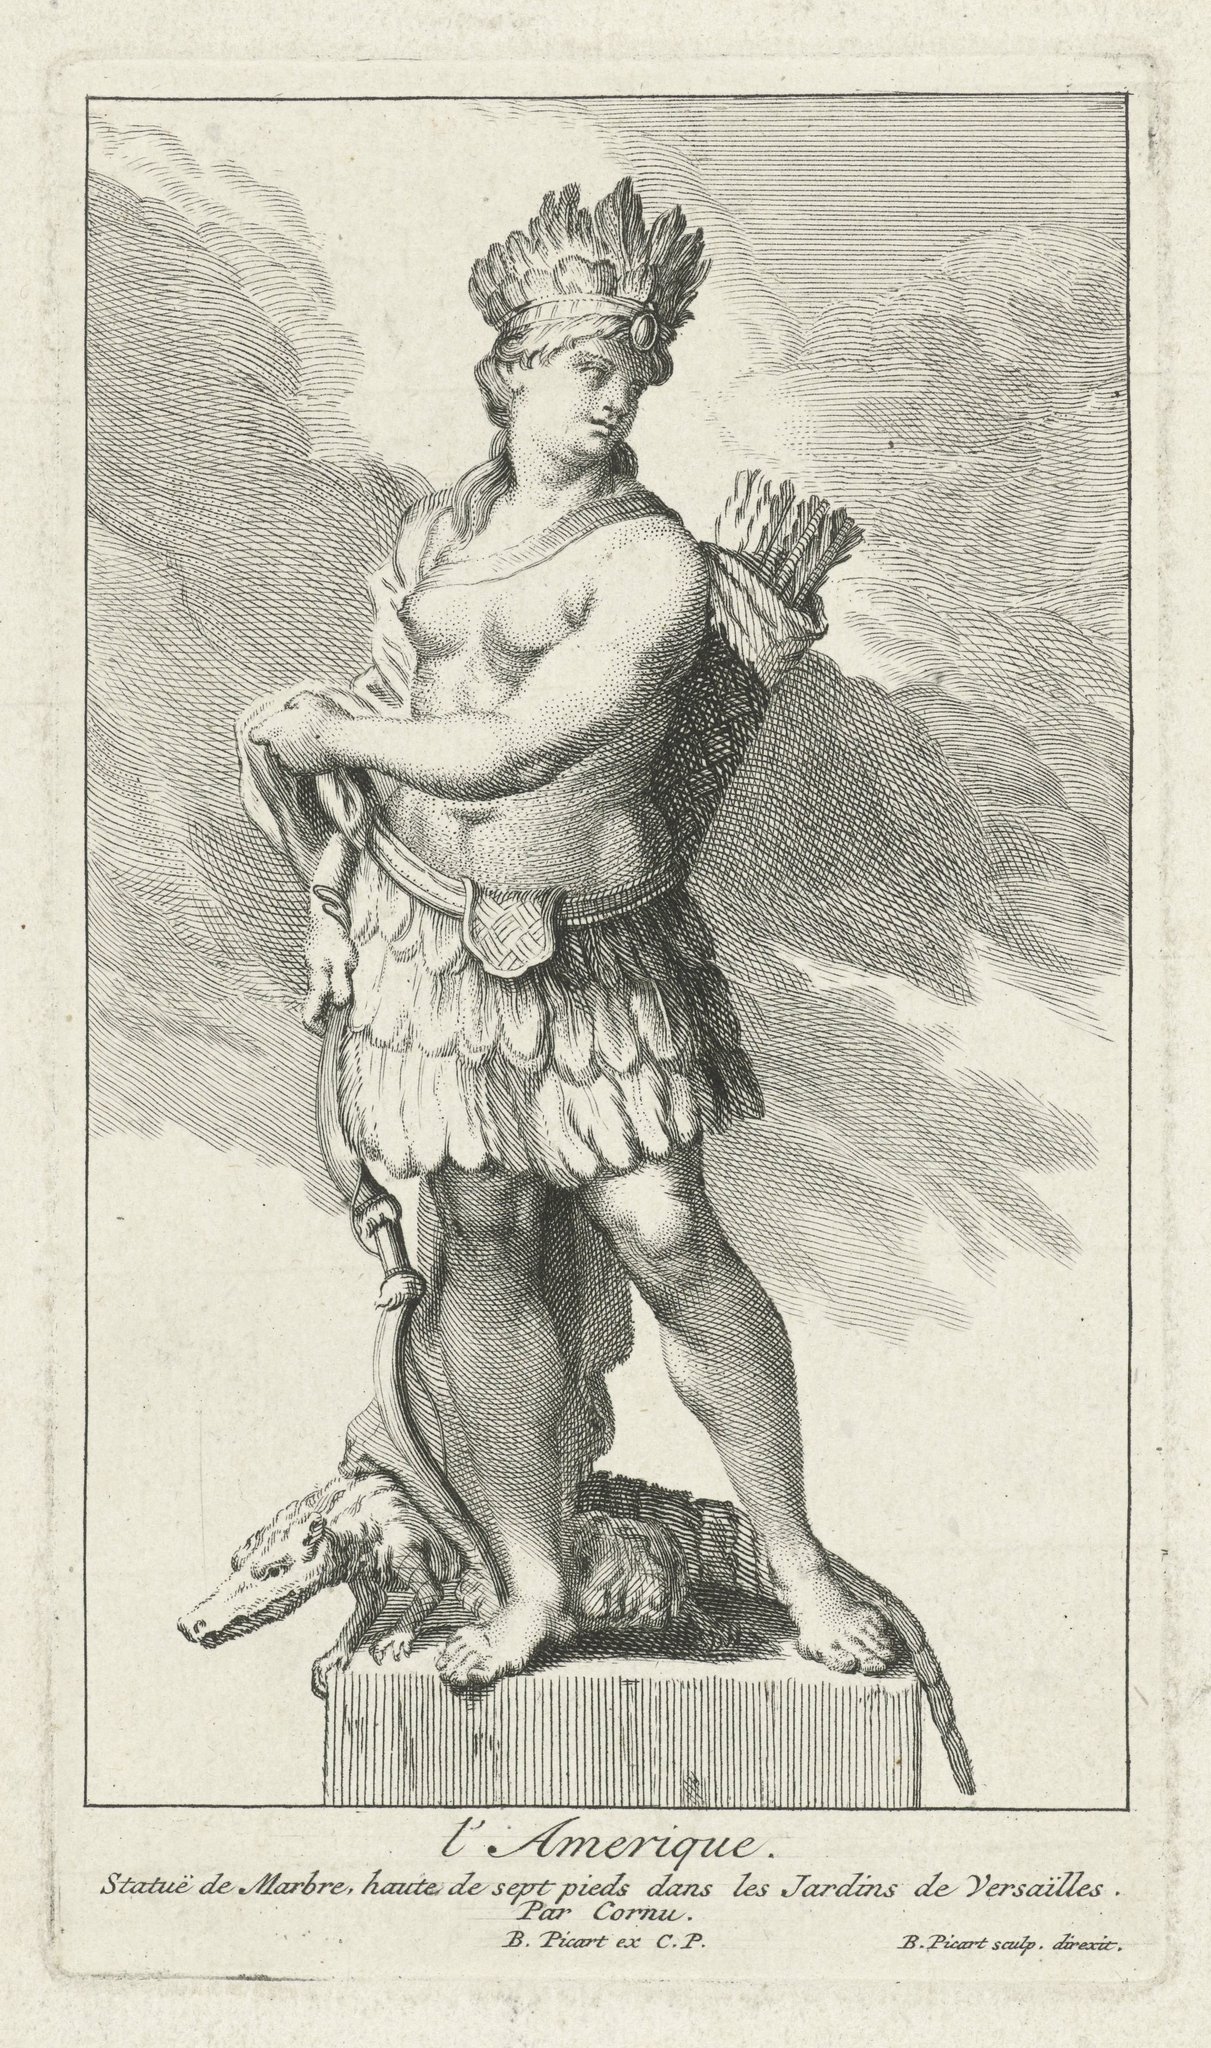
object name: print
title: Amerika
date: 1709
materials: paper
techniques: engraving, etching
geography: paris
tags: america represented allegorically; 'america' (ripa), piece of sculpture, reproduction of a piece of sculpture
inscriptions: collector's mark: Lugt 240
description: Standbeeld in de tuinen van Versailles. De vrouwelijke personificatie van Amerika, met een hoofdtooi, een pijlenkoker op de rug en een boog in de hand. Aan haar voeten een krokodil. In de marge een onderschrift in het Frans.